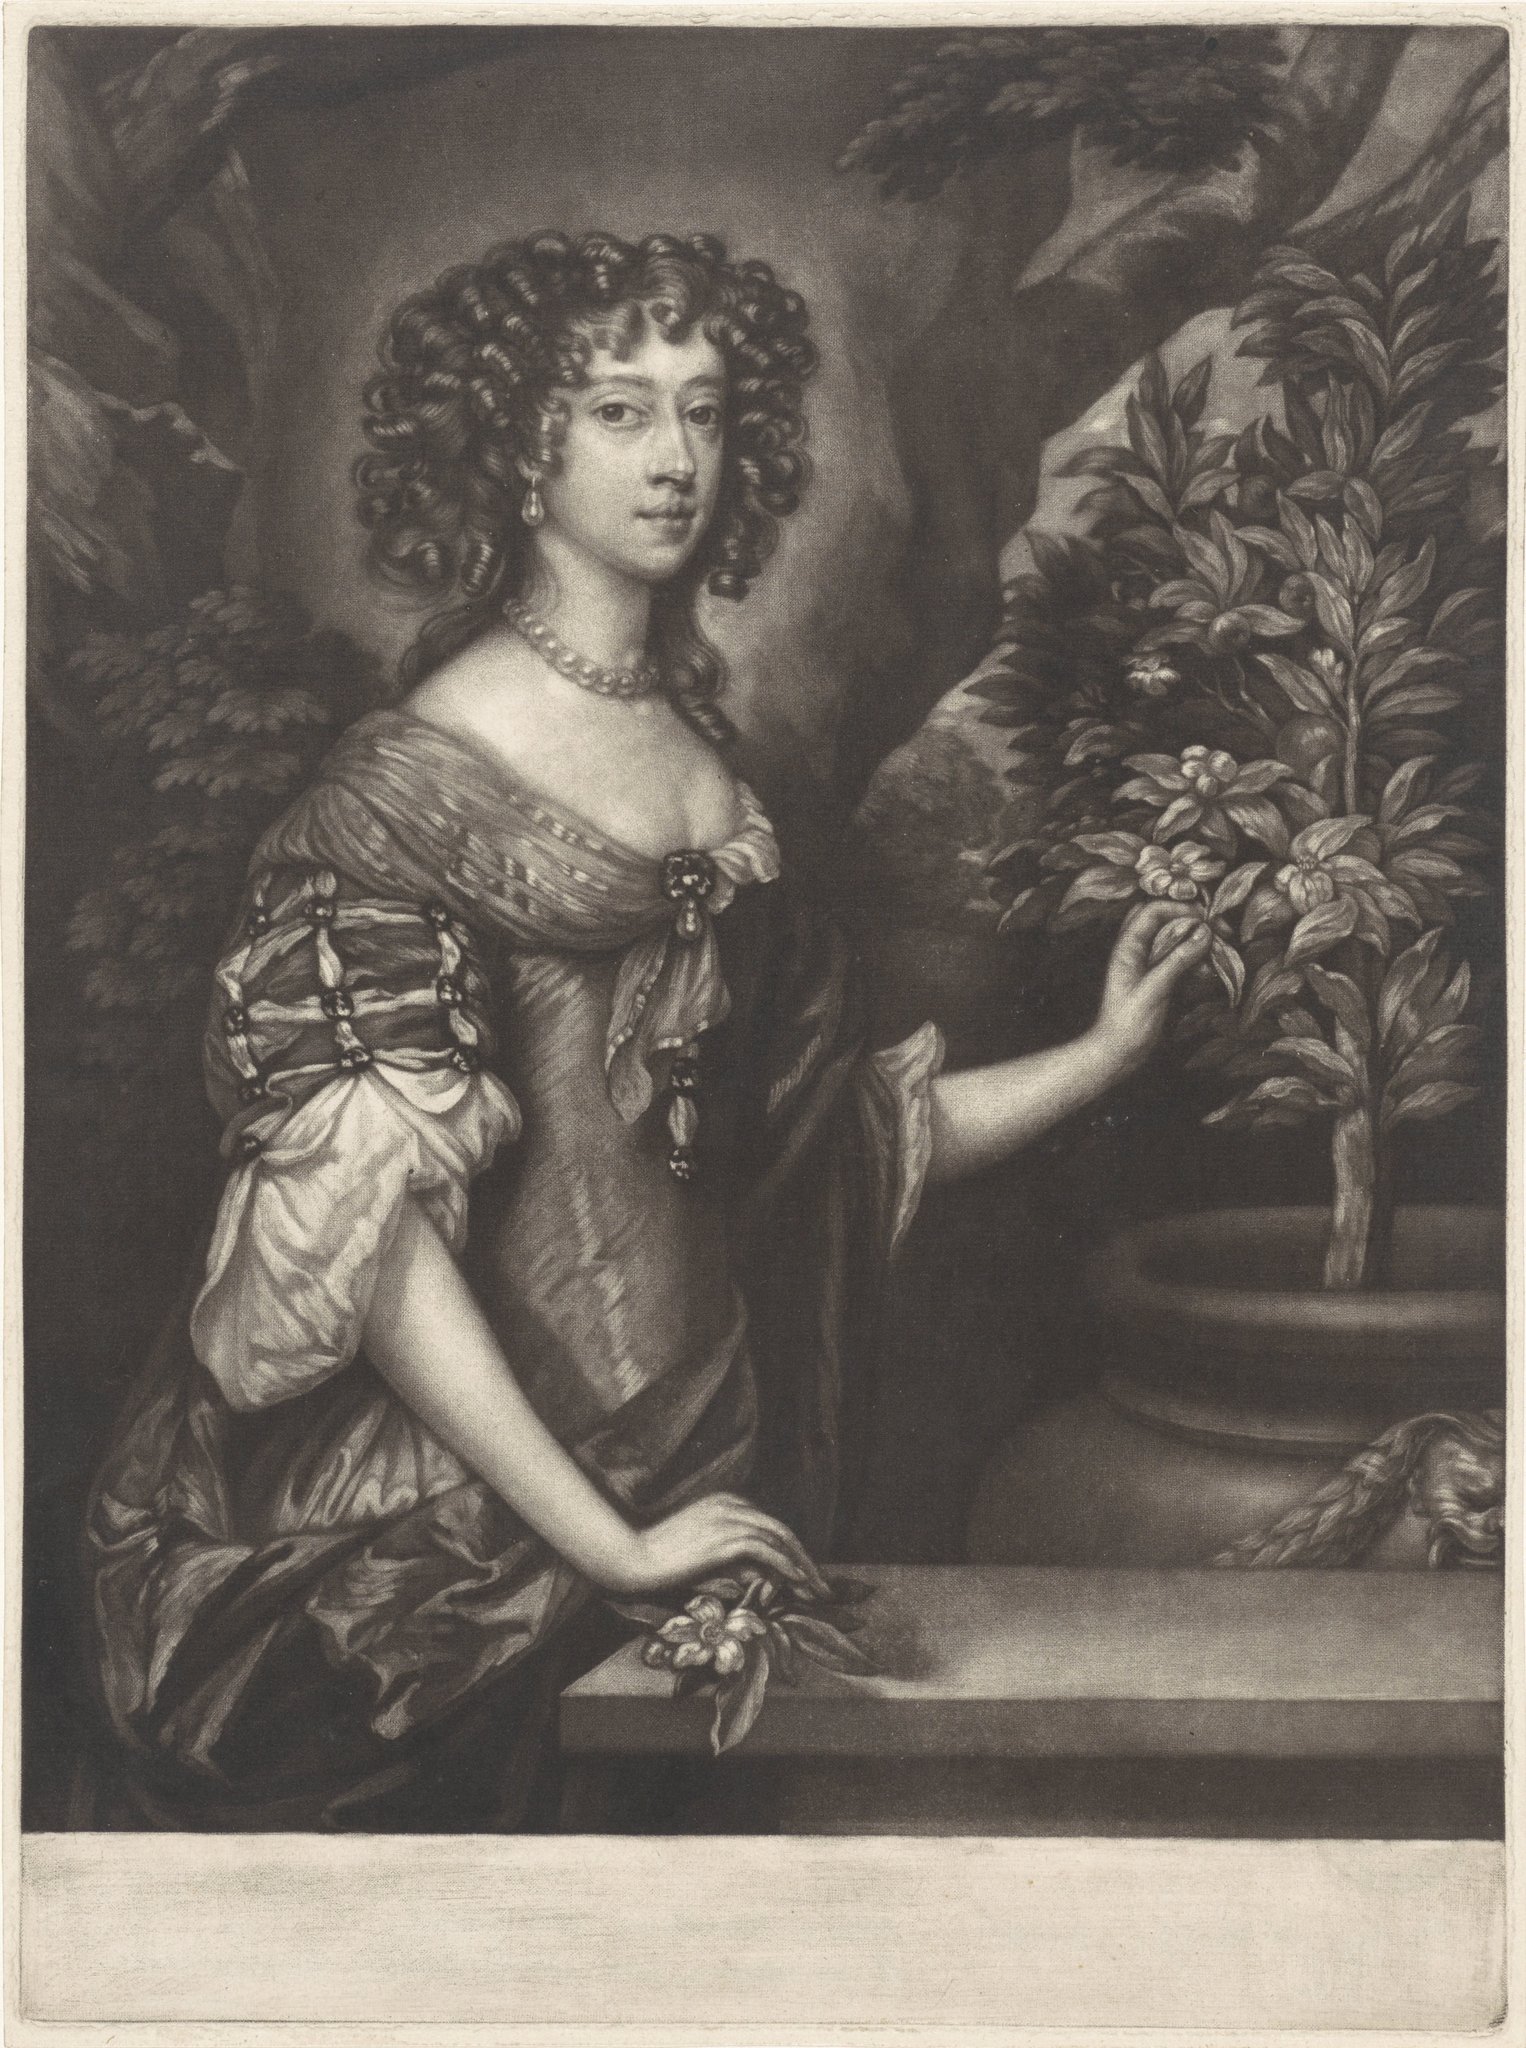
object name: print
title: Portret van Maria Beatrice van Modena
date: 1673-1690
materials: paper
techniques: mezzotint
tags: paris, flowers, garden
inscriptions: collector's mark: Lugt 10, collector's mark: Lugt 11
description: Maria Beatrice Eleanor Anne Margaret Isabella d’Este, dochter van Alfonso d’Este III, hertog van Modena. Ze was vanaf 1685 tot 1689 koningin van Engeland.